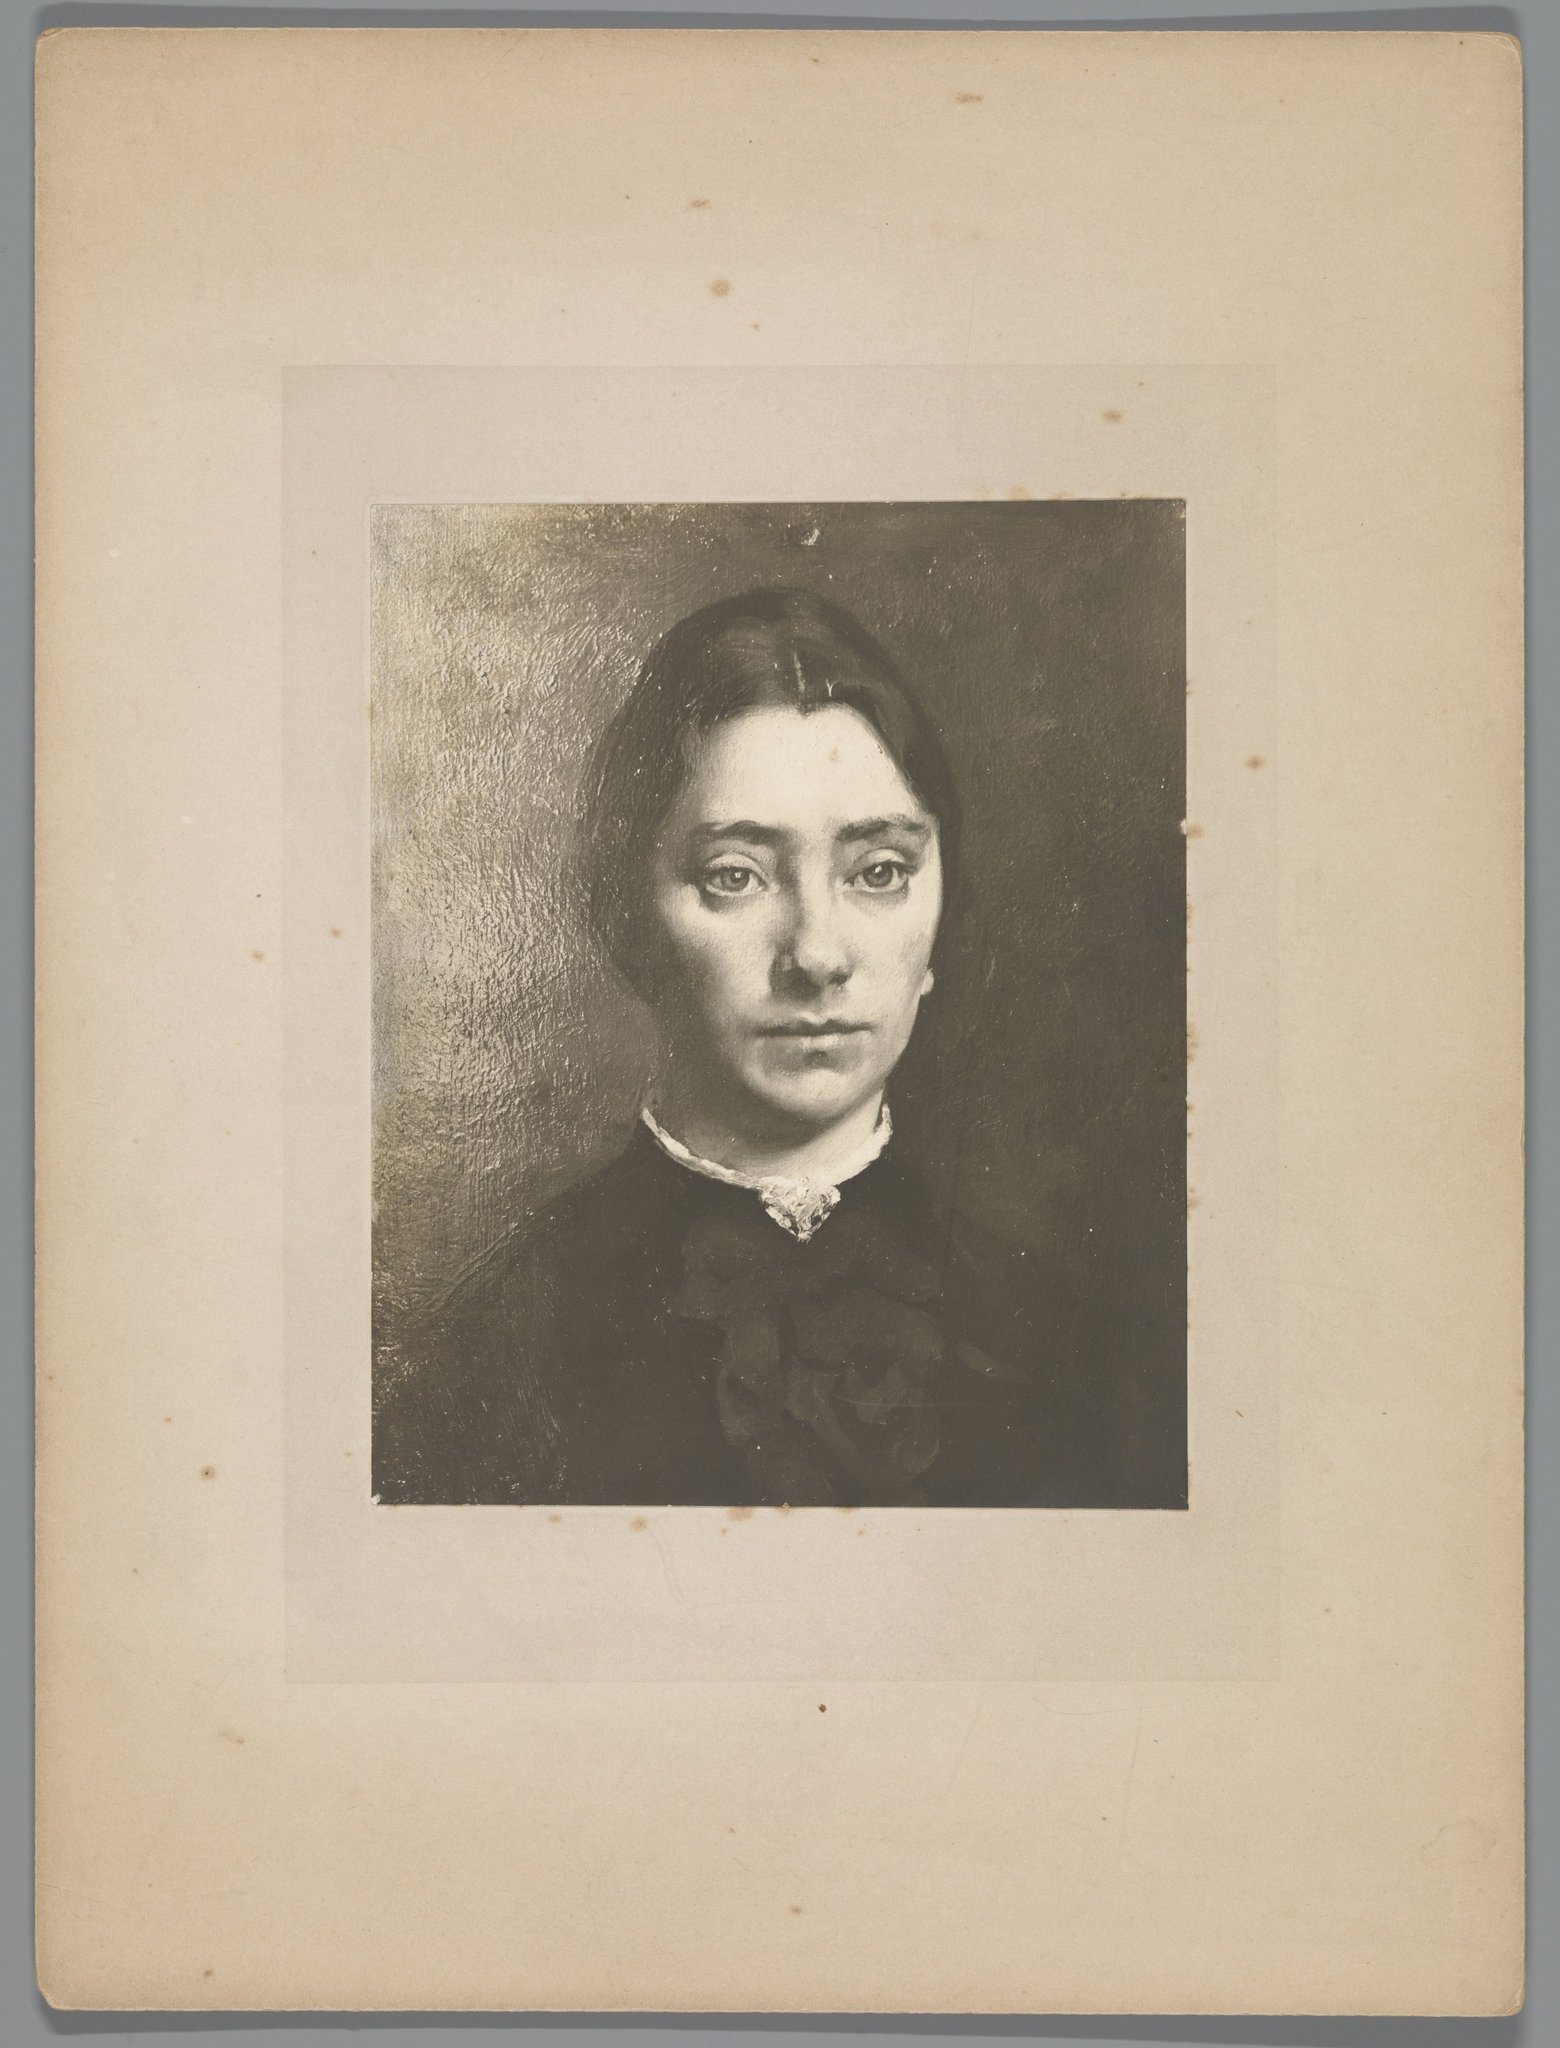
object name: photograph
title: Reproductie naar een foto, schilderij, tekening of prent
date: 1860-1915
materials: cardboard, paper, photographic support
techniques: gelatin silver print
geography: netherlands